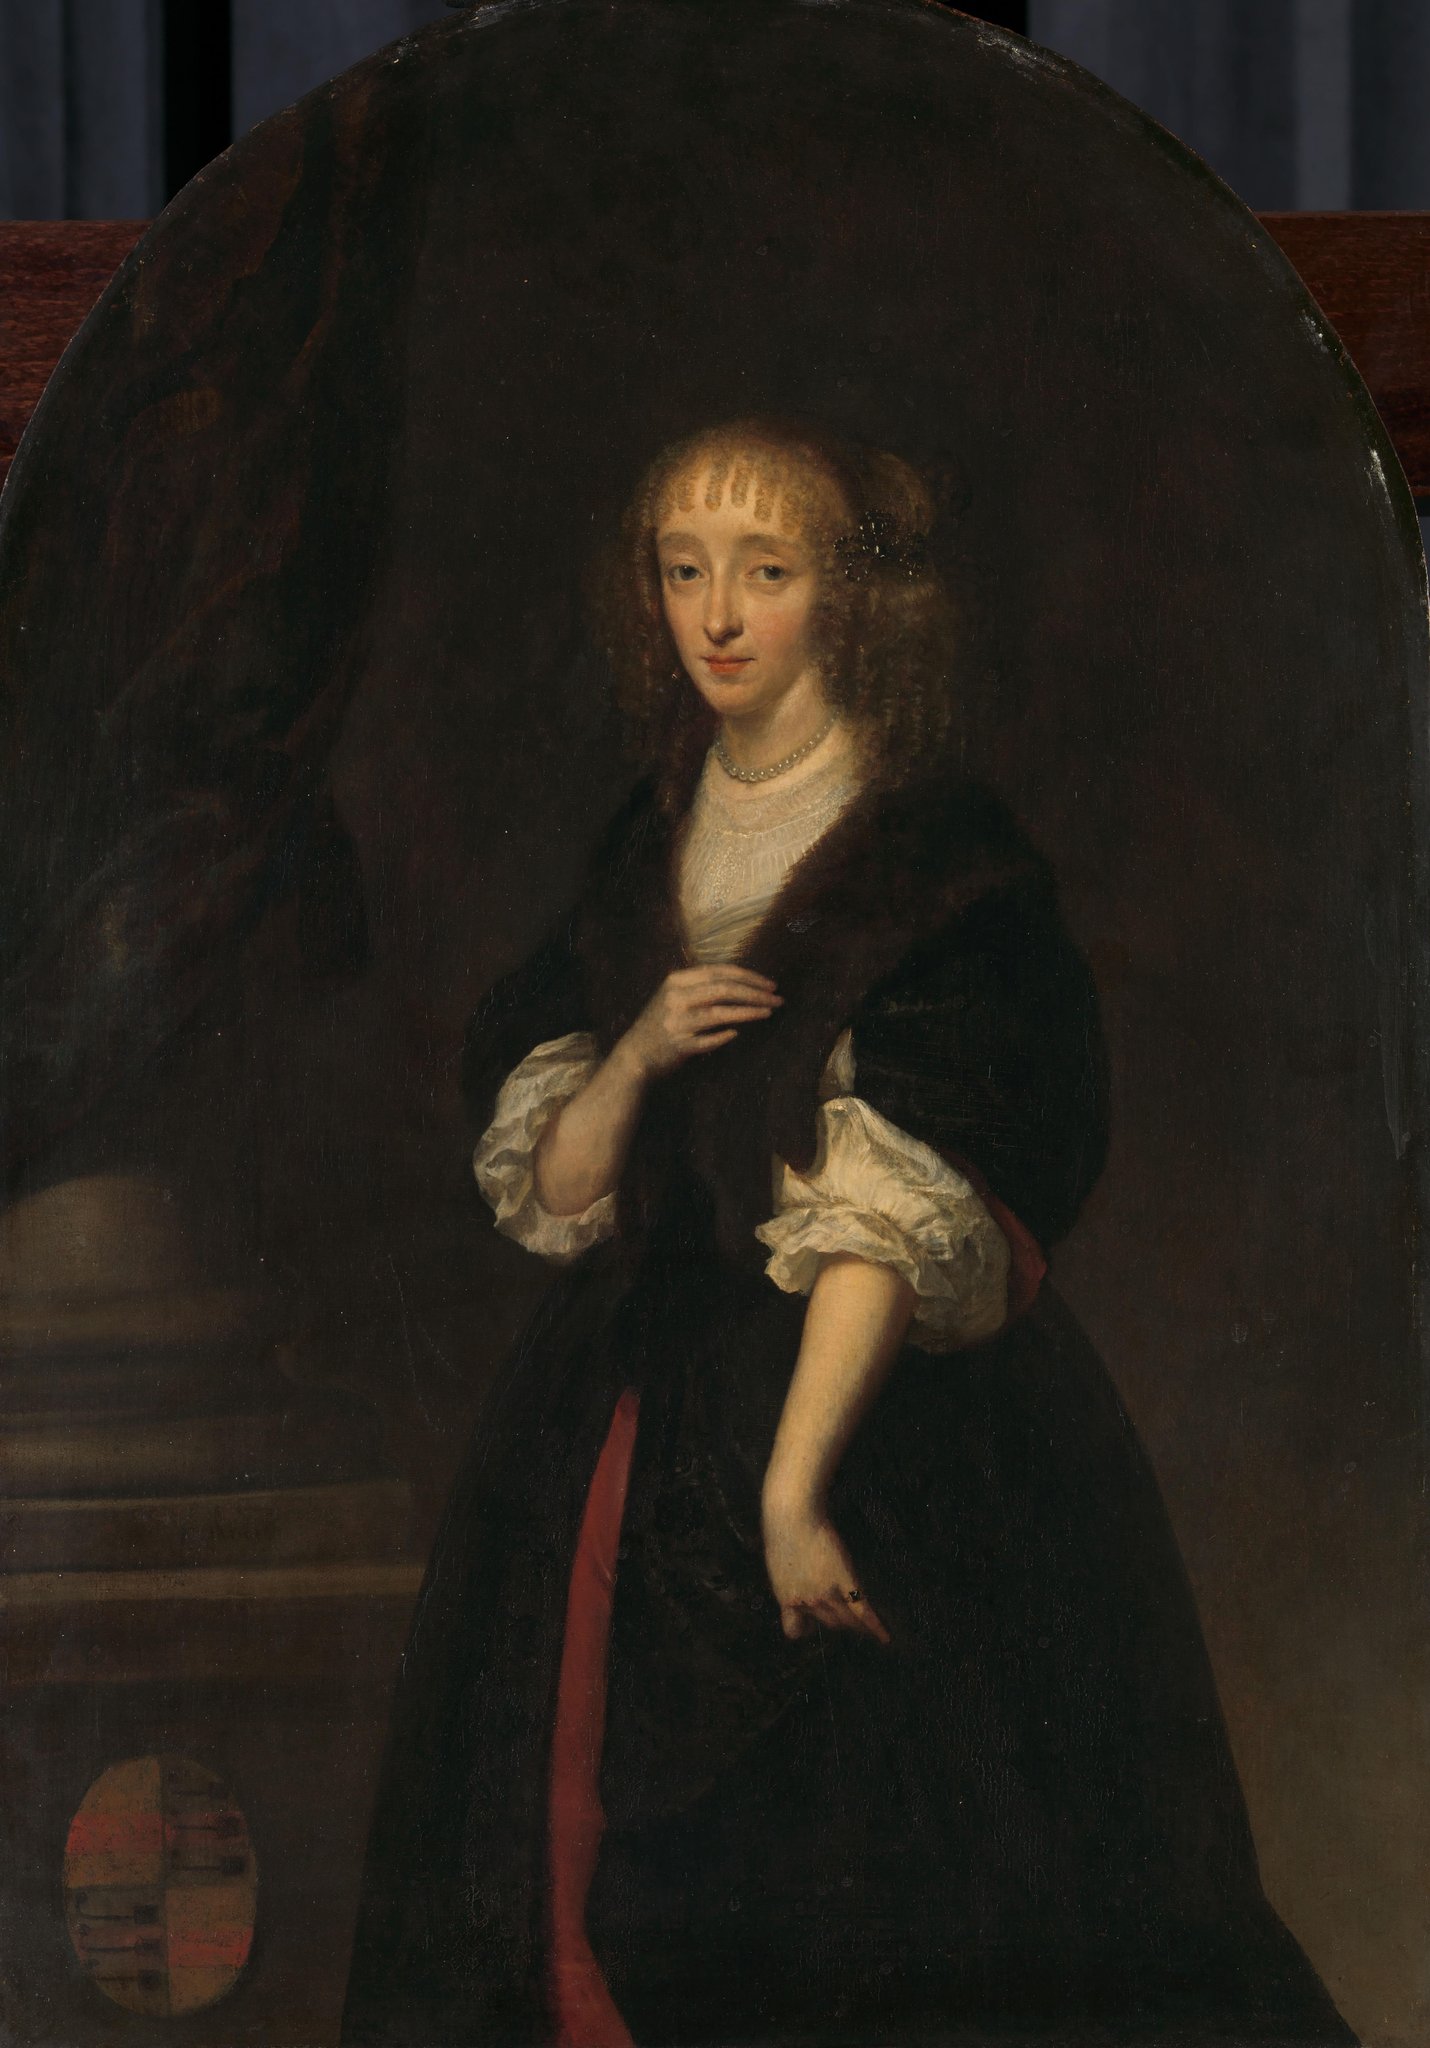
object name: painting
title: Portrait of Jacoba Bicker (1640-95), wife of Pieter de Graeff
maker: caspar netscher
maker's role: draughtsman, painter, print maker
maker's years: 1639-1684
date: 1663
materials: oil, panel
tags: amsterdam, politician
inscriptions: signature: ‘Netscher’, coat of arms, bottom left: ‘gevierendeeld: I en IV in goud een rode dwarsbalk, II en III in zilver drie zwarte helmstokken boven elkaar.’, inscription: ‘AEtat 23’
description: Portret van Jacoba Bicker, echtgenote van Pieter de Graeff. Kniestuk, staande naast een zuil. Op het basement van de zuil haar familiewapen. Pendant van SK-A-3977.